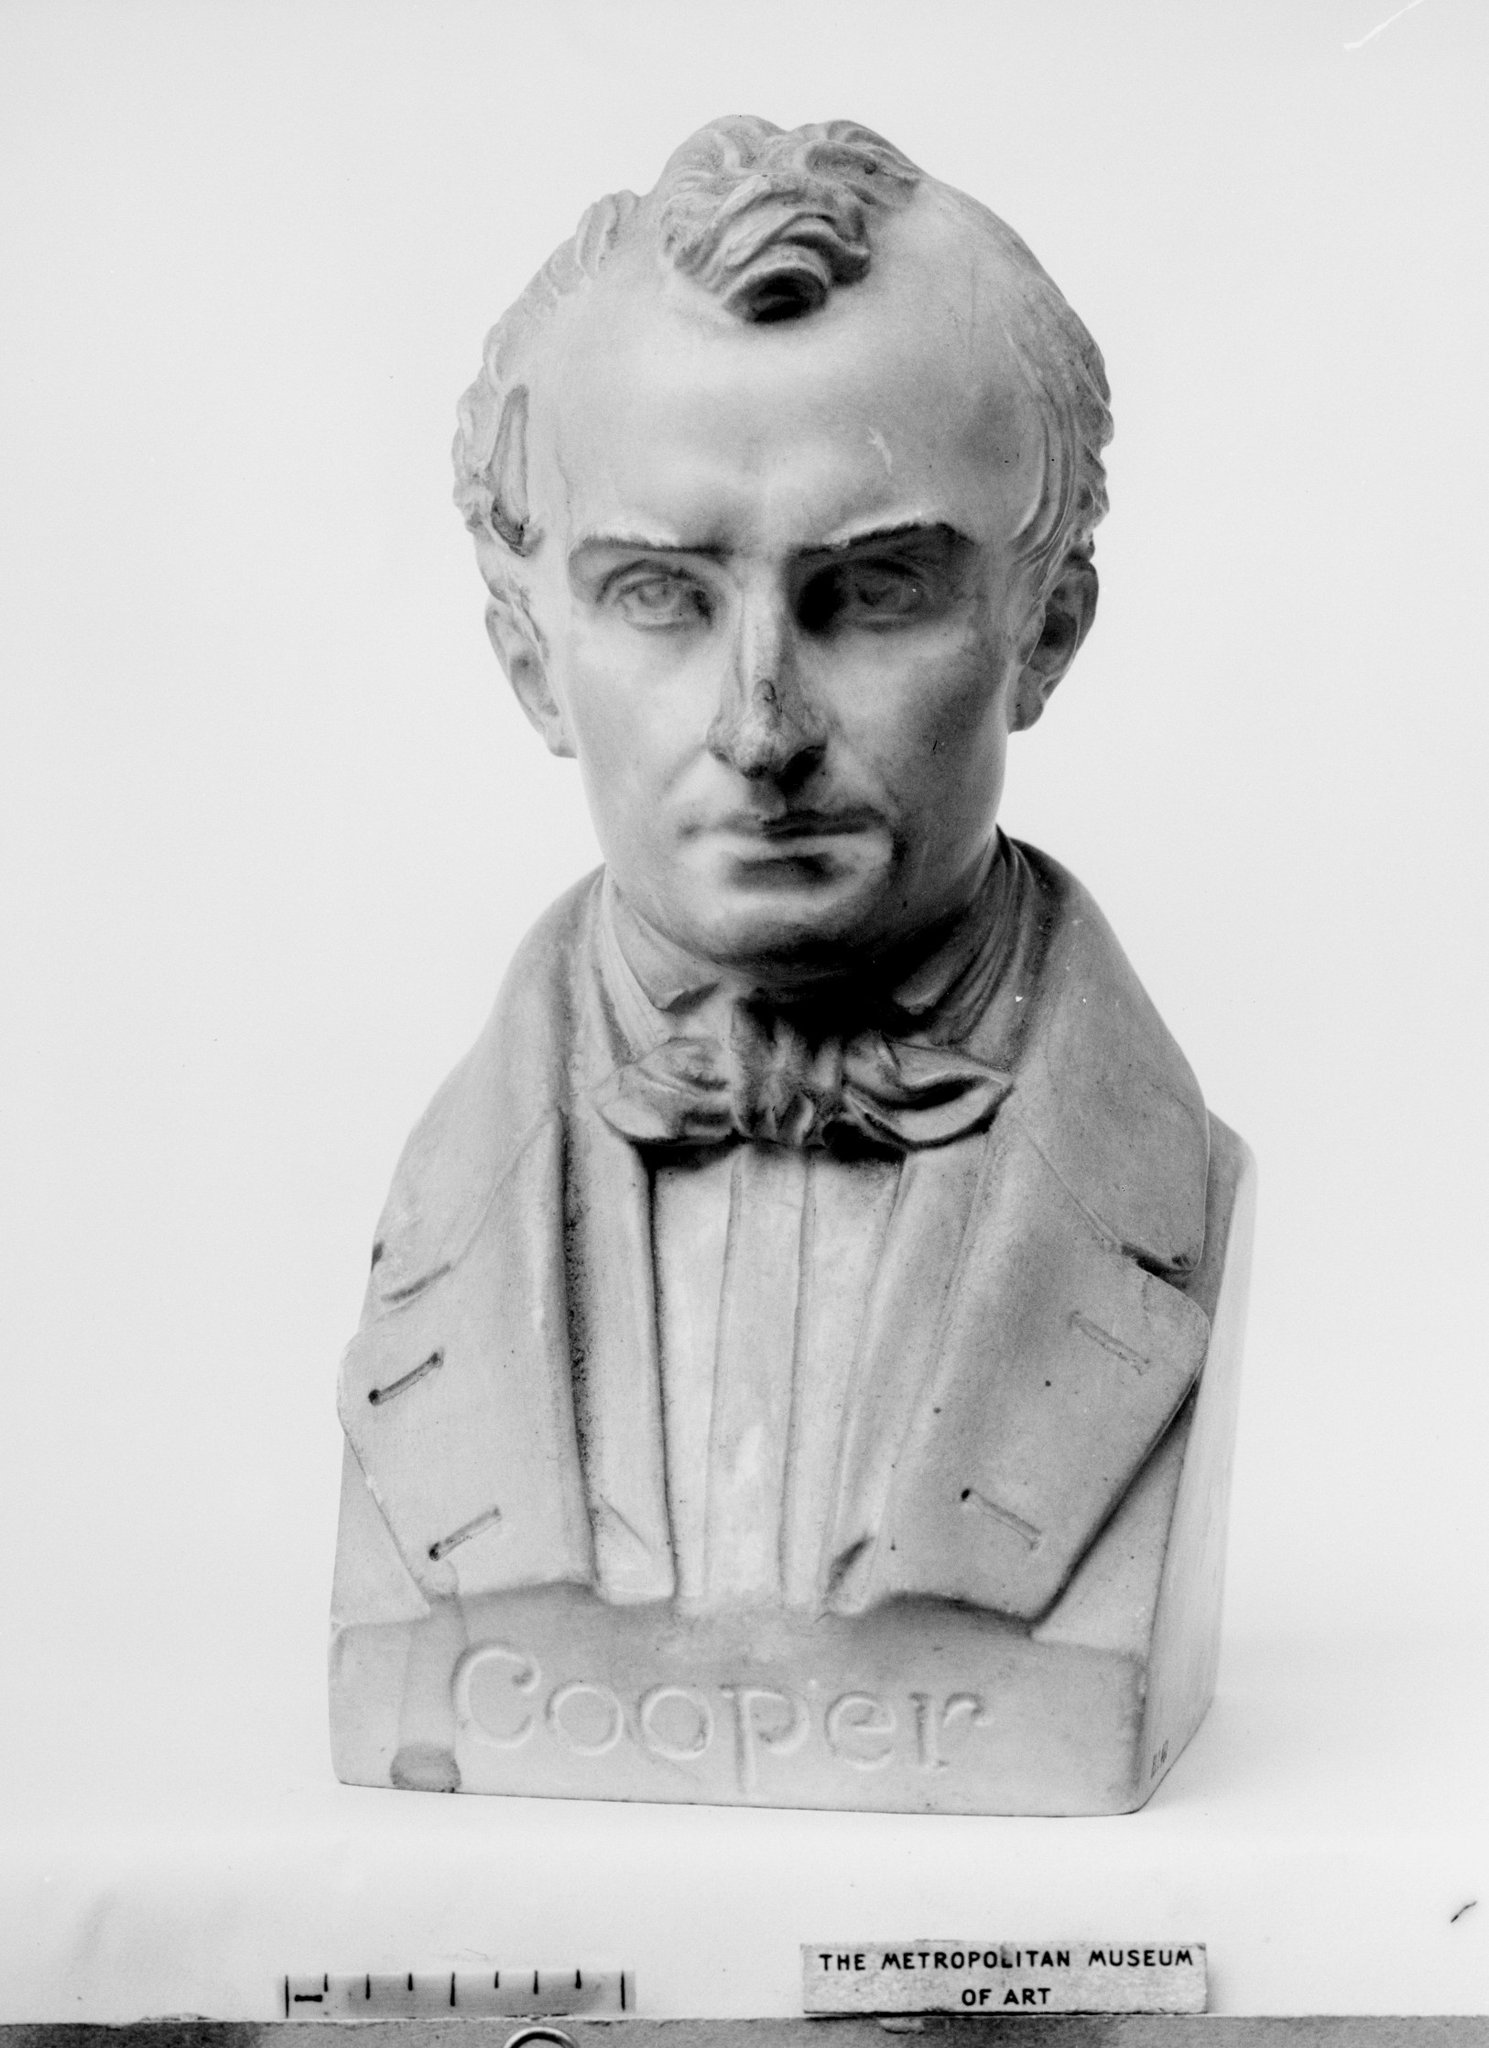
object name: bust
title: Bust of James Fenimore Cooper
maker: pierre joseph chardigny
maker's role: maker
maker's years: 1794-1866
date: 1853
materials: plaster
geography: france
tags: men,portraits